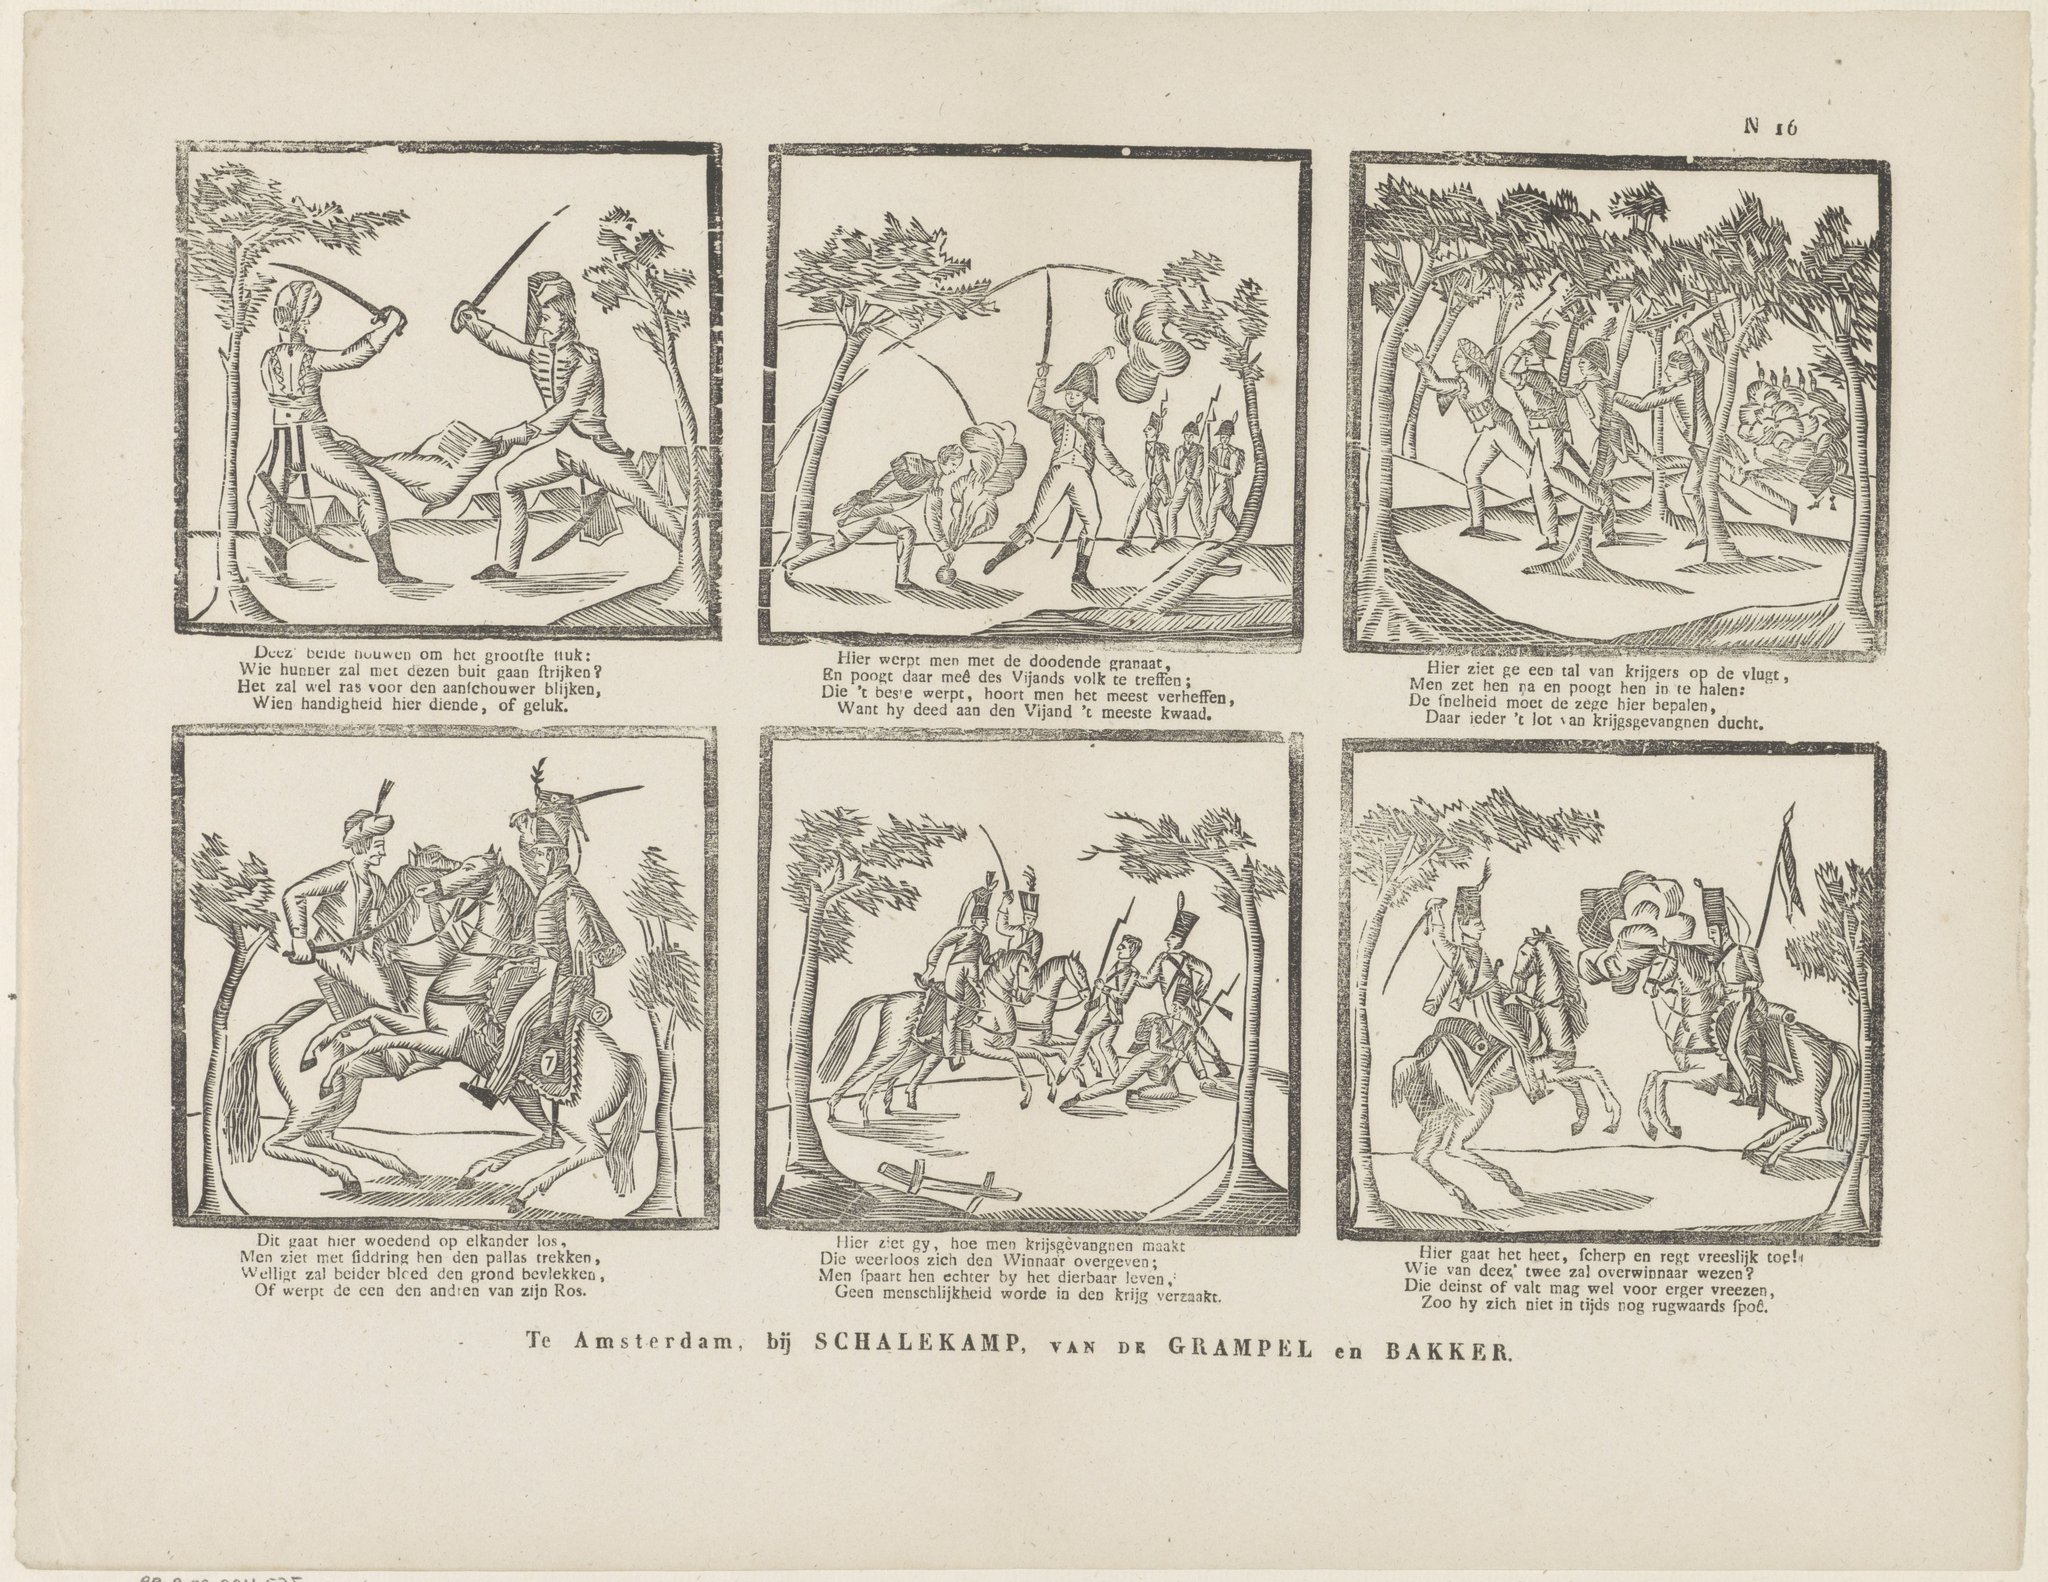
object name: print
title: Militairen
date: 1822-1849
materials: paper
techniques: letterpress printing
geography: deventer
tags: battle, warfare; military affairs (+ cavalry, horsemen), the soldier; the soldier's life, fencing (sport)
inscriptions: collector's mark: Lugt 2760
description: Uitgave van nr. 16 uit de fondslijst van Jan de Lange (II) met het adres van de wederverkoper Schalekamp, Van de Grampel & Bakker.